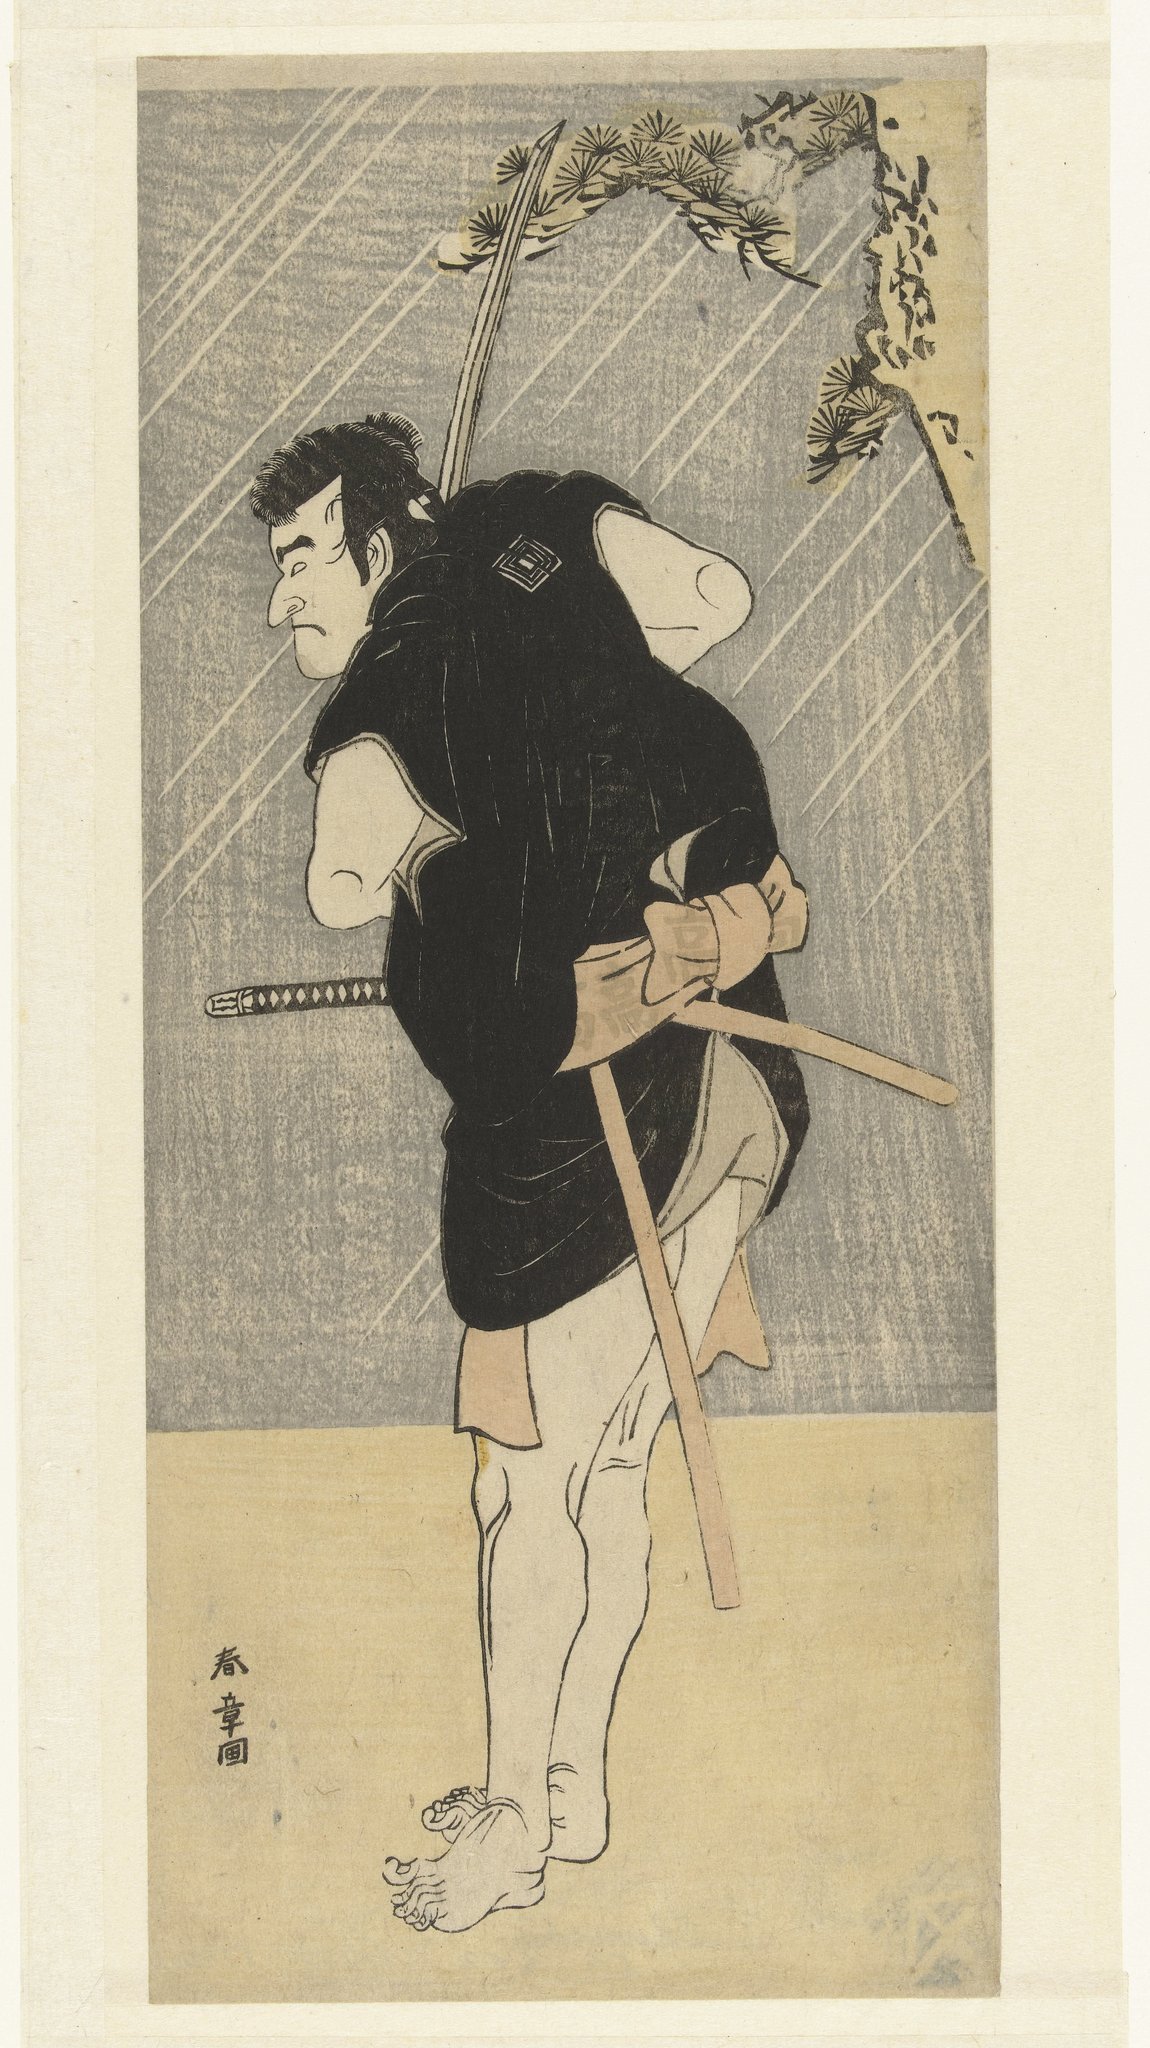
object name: print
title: Acteur Ichikawa Danjuro, waarschijnlijk als de rover Sadakuro in het stuk over de 47 Ronin. Hosoe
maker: utagawa toyomaru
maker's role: print maker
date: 1790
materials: paper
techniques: woodcut, nishiki e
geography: japan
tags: standing figure, rain, portrait of actor, actress